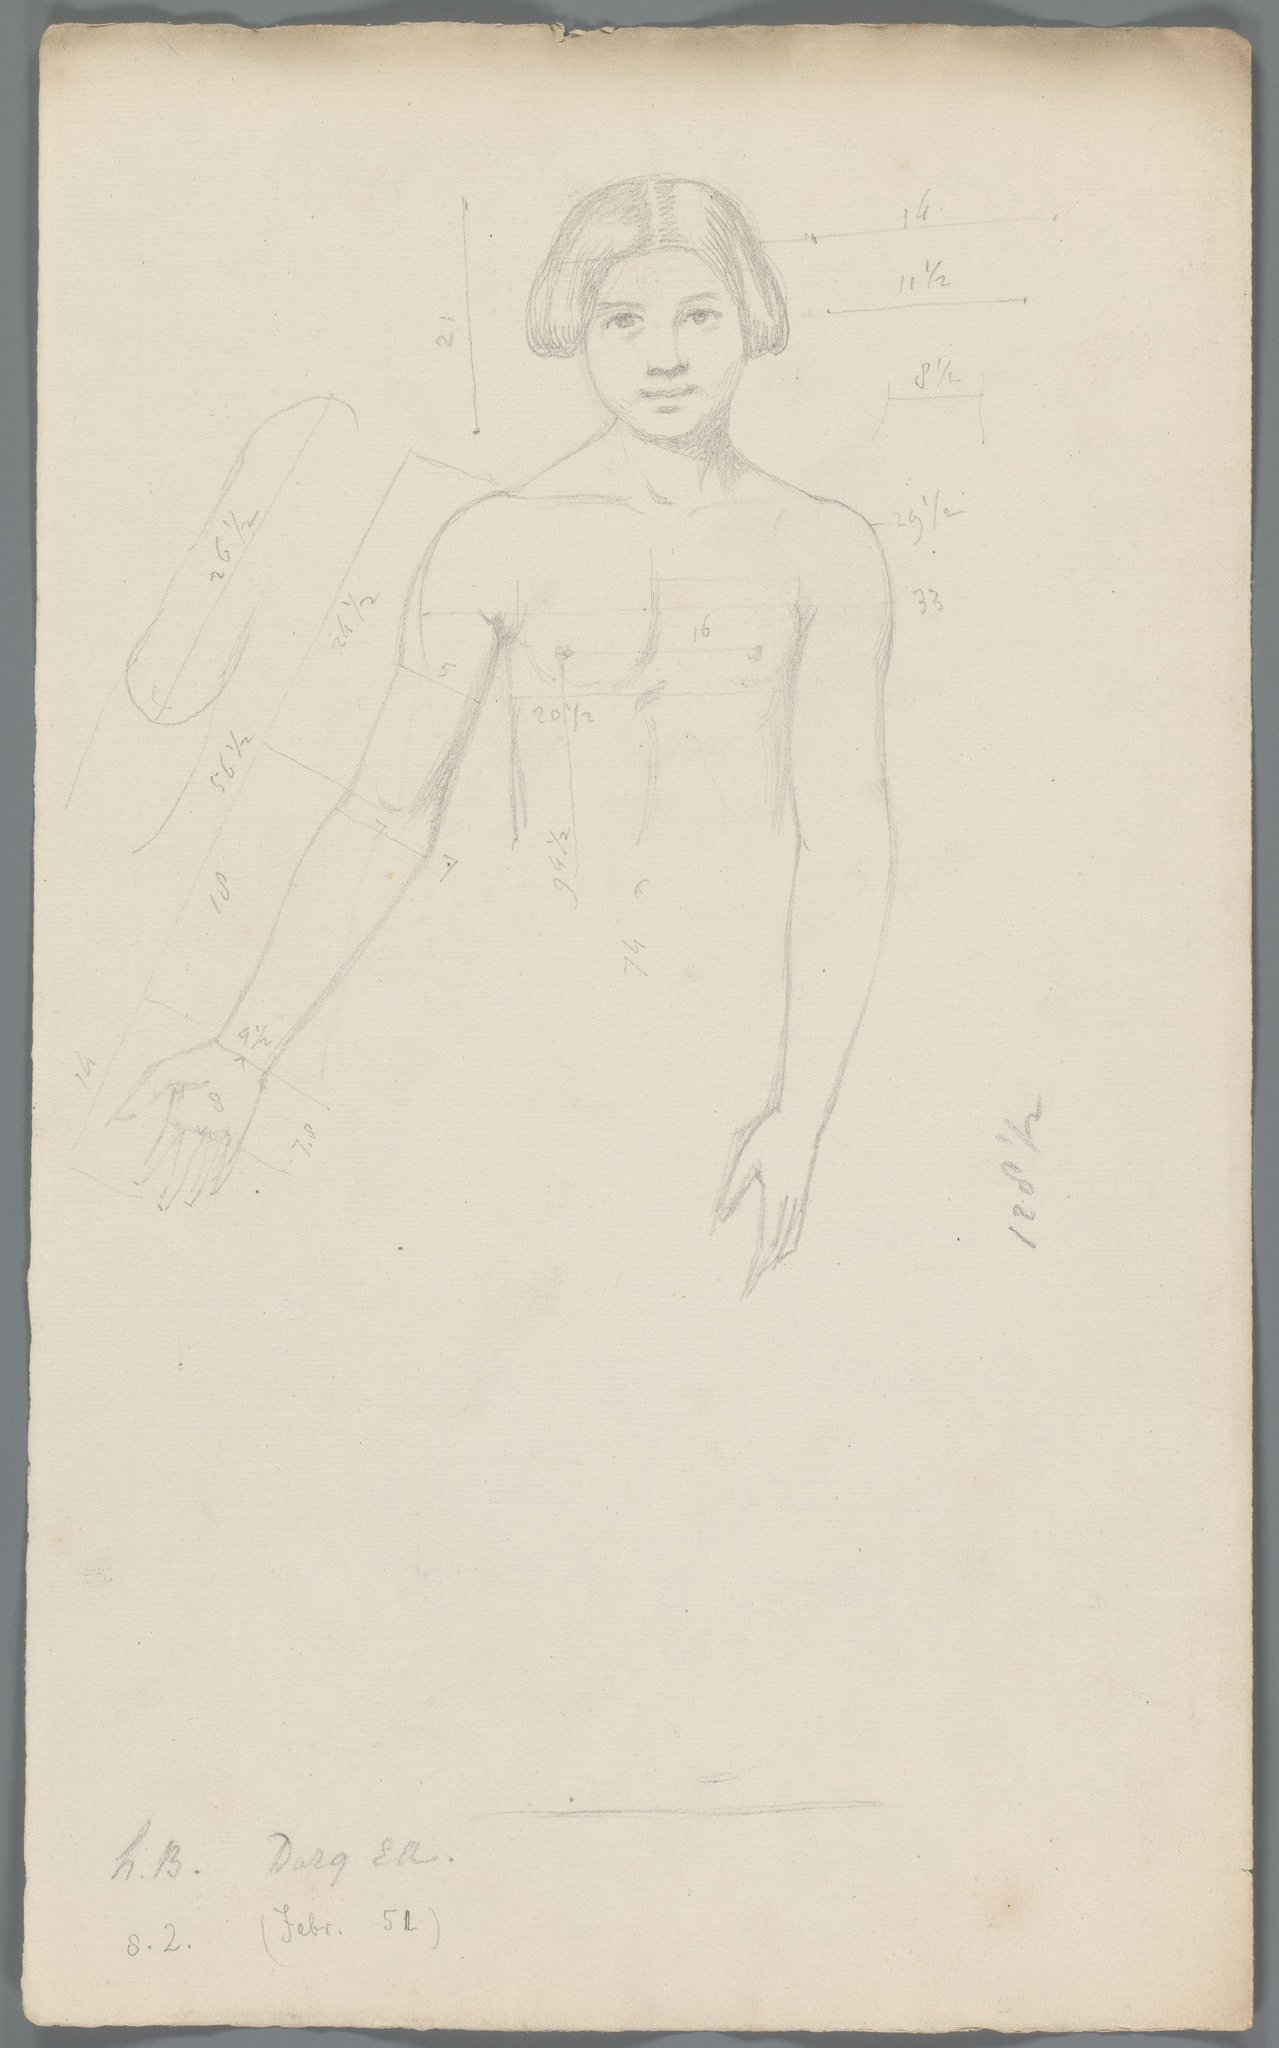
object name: drawing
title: Proportiestudie van het bovenlichaam van een meisje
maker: jacobus everhardus josephus van den berg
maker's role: draughtsman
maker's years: 1802-1861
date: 1851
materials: paper, pencil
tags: parts of the human body (skeleton excepted) - aa - female human figure, standing figure (canon, proportions) - aa - female human figure, child (at home) - aa - girl